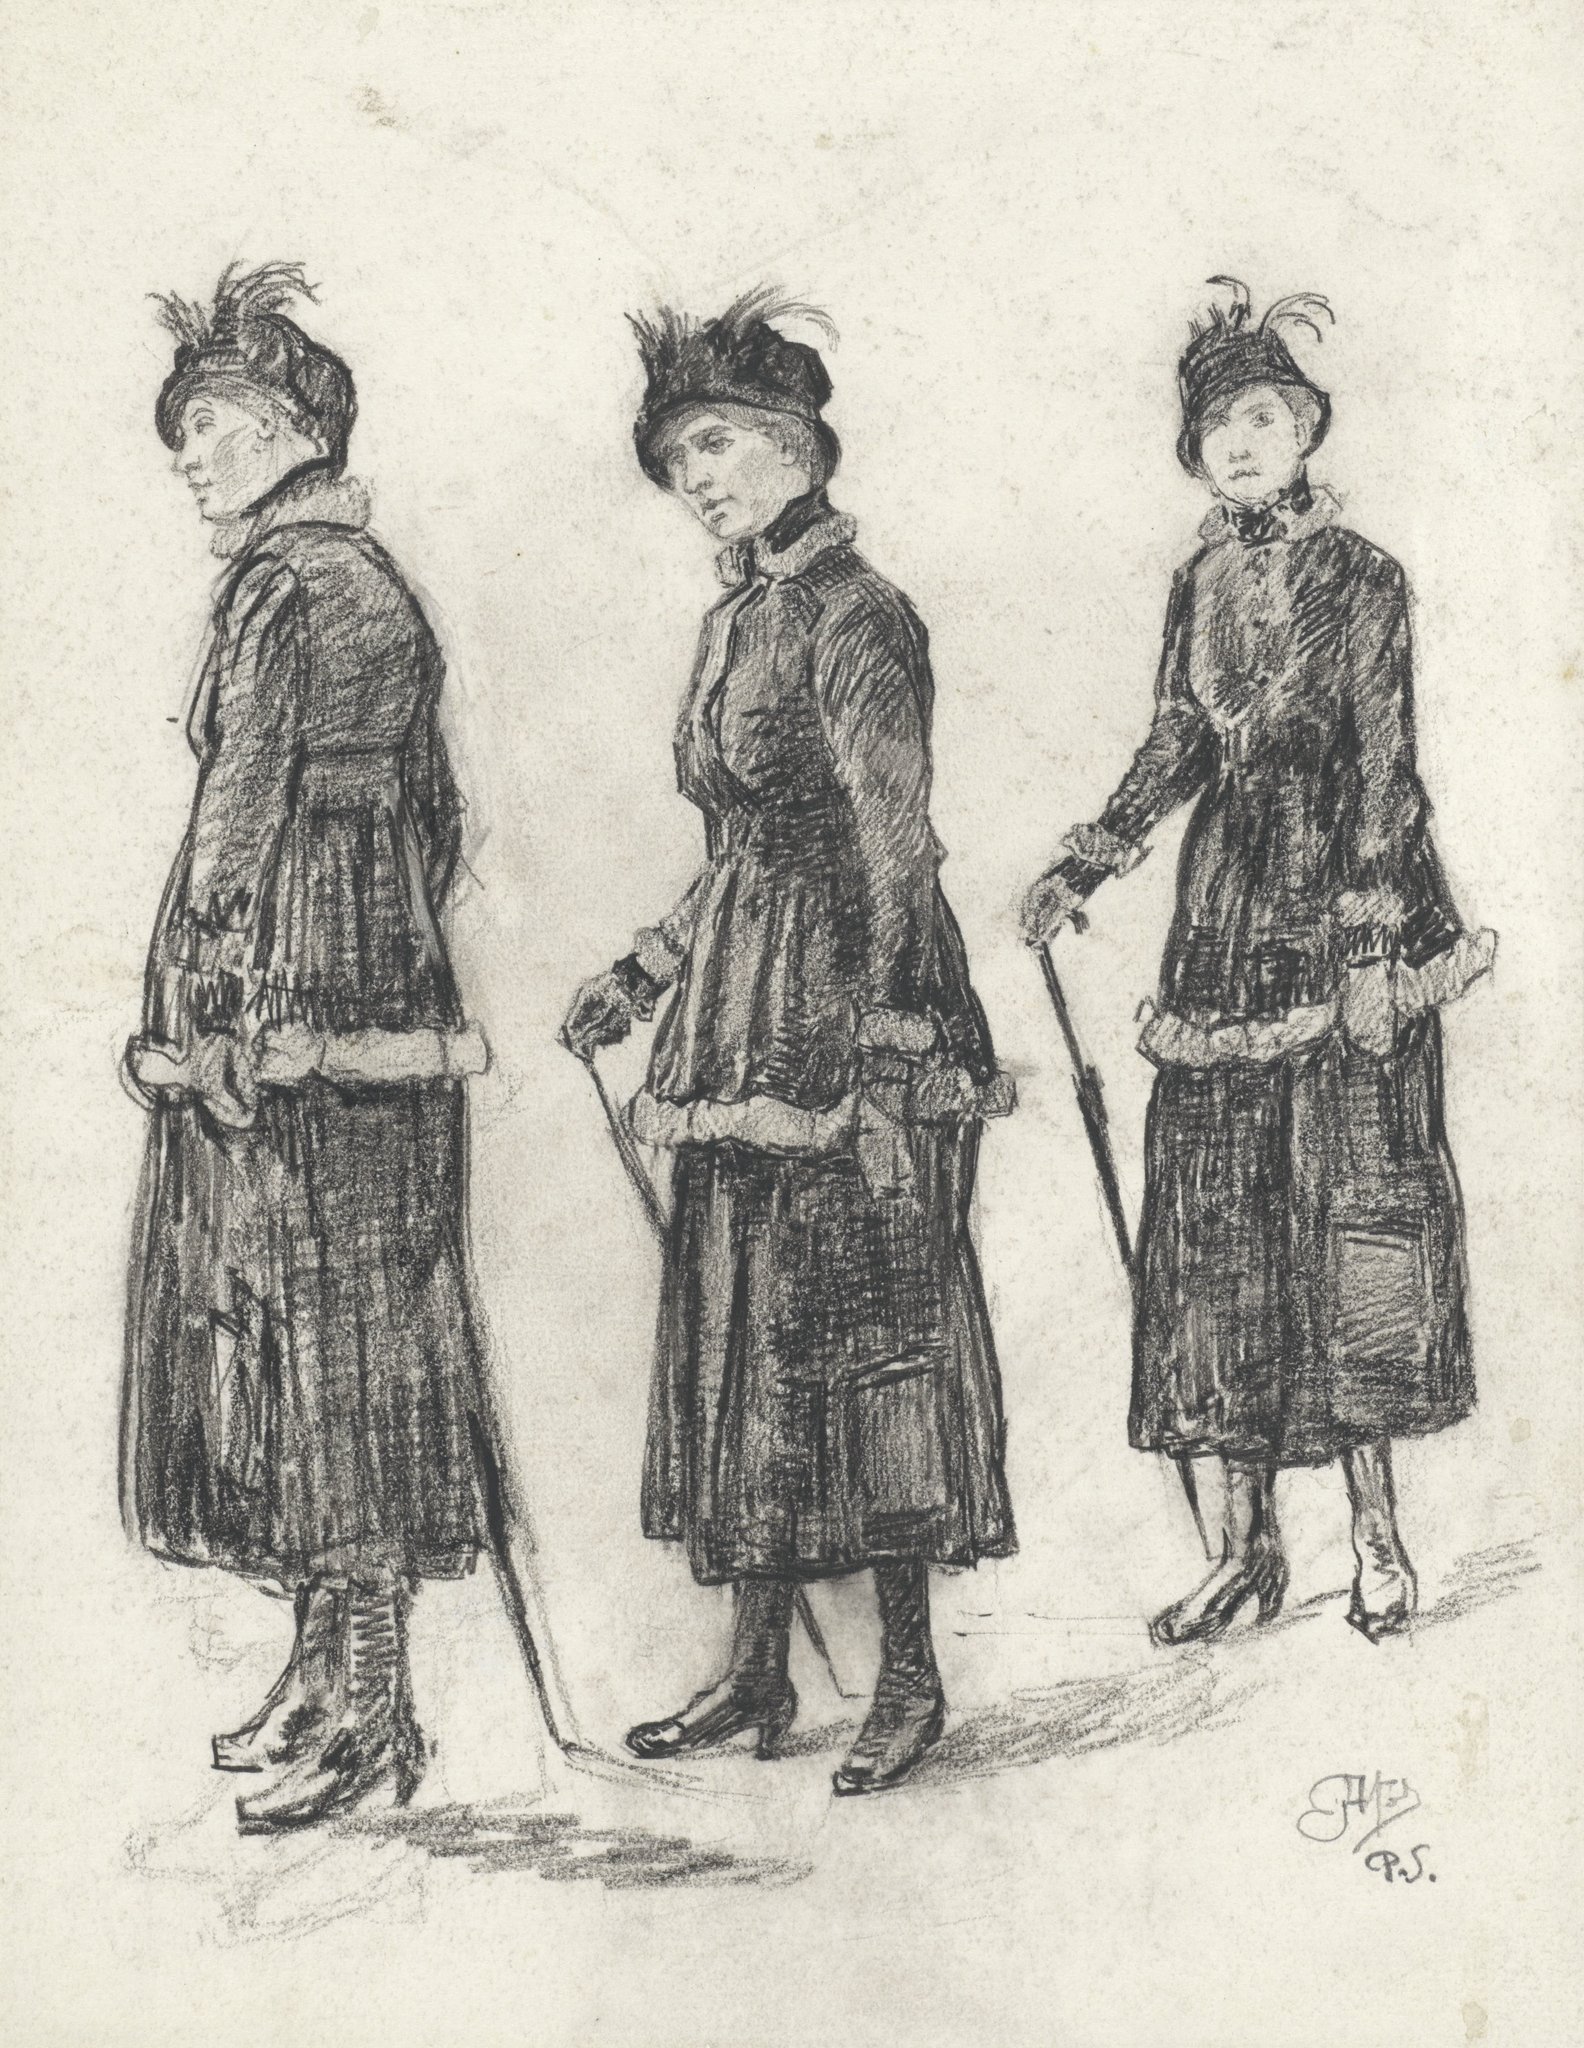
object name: drawing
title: Drie studies van een wandelende dame in mantelkostuum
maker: johannes abraham mondt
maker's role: draughtsman, print maker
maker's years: 1859-1941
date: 1869-1941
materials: chalk, paper